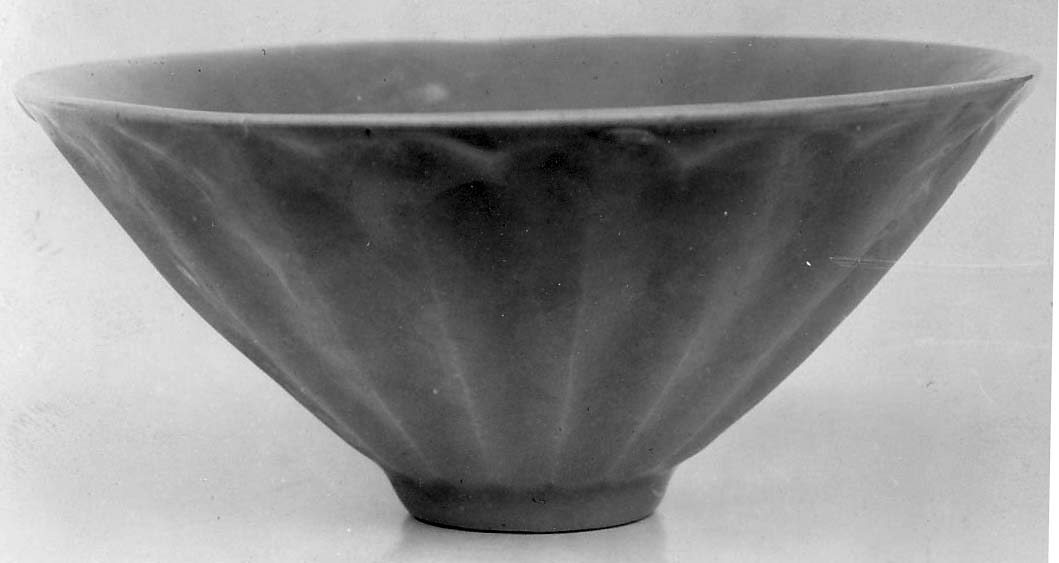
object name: bowl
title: Chrysanthemum Bowl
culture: japanese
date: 901-1300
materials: ceramic glaze, glaze